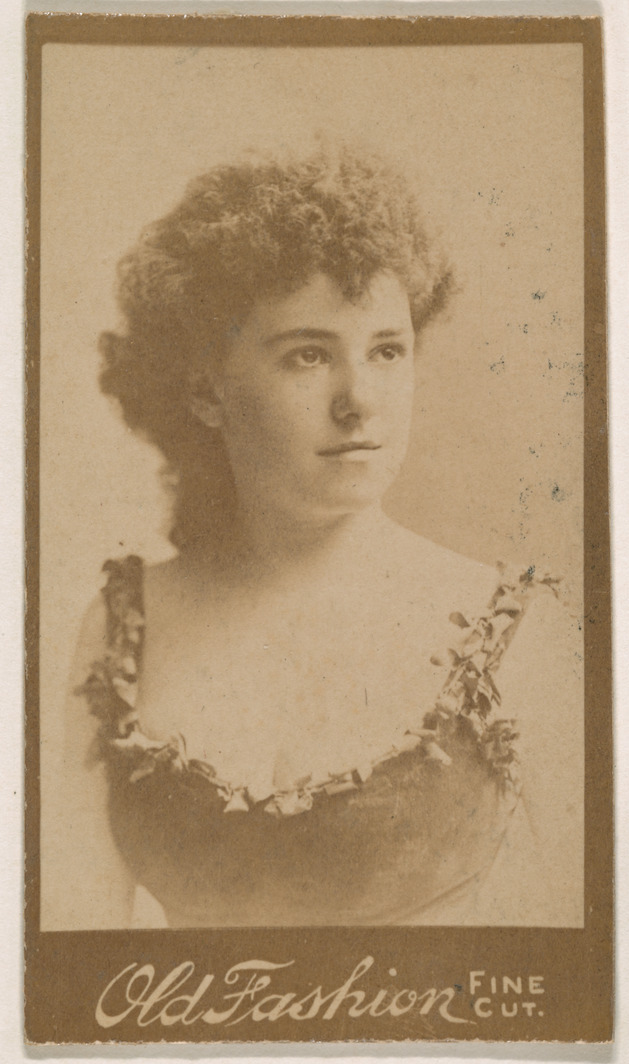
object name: photograph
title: Actress wearing dress with ivy affixed along neckline, from the Actresses series (N664) promoting Old Fashion Fine Cut Tobacco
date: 1888-1890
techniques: albumen silver print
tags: portraits,women,actresses